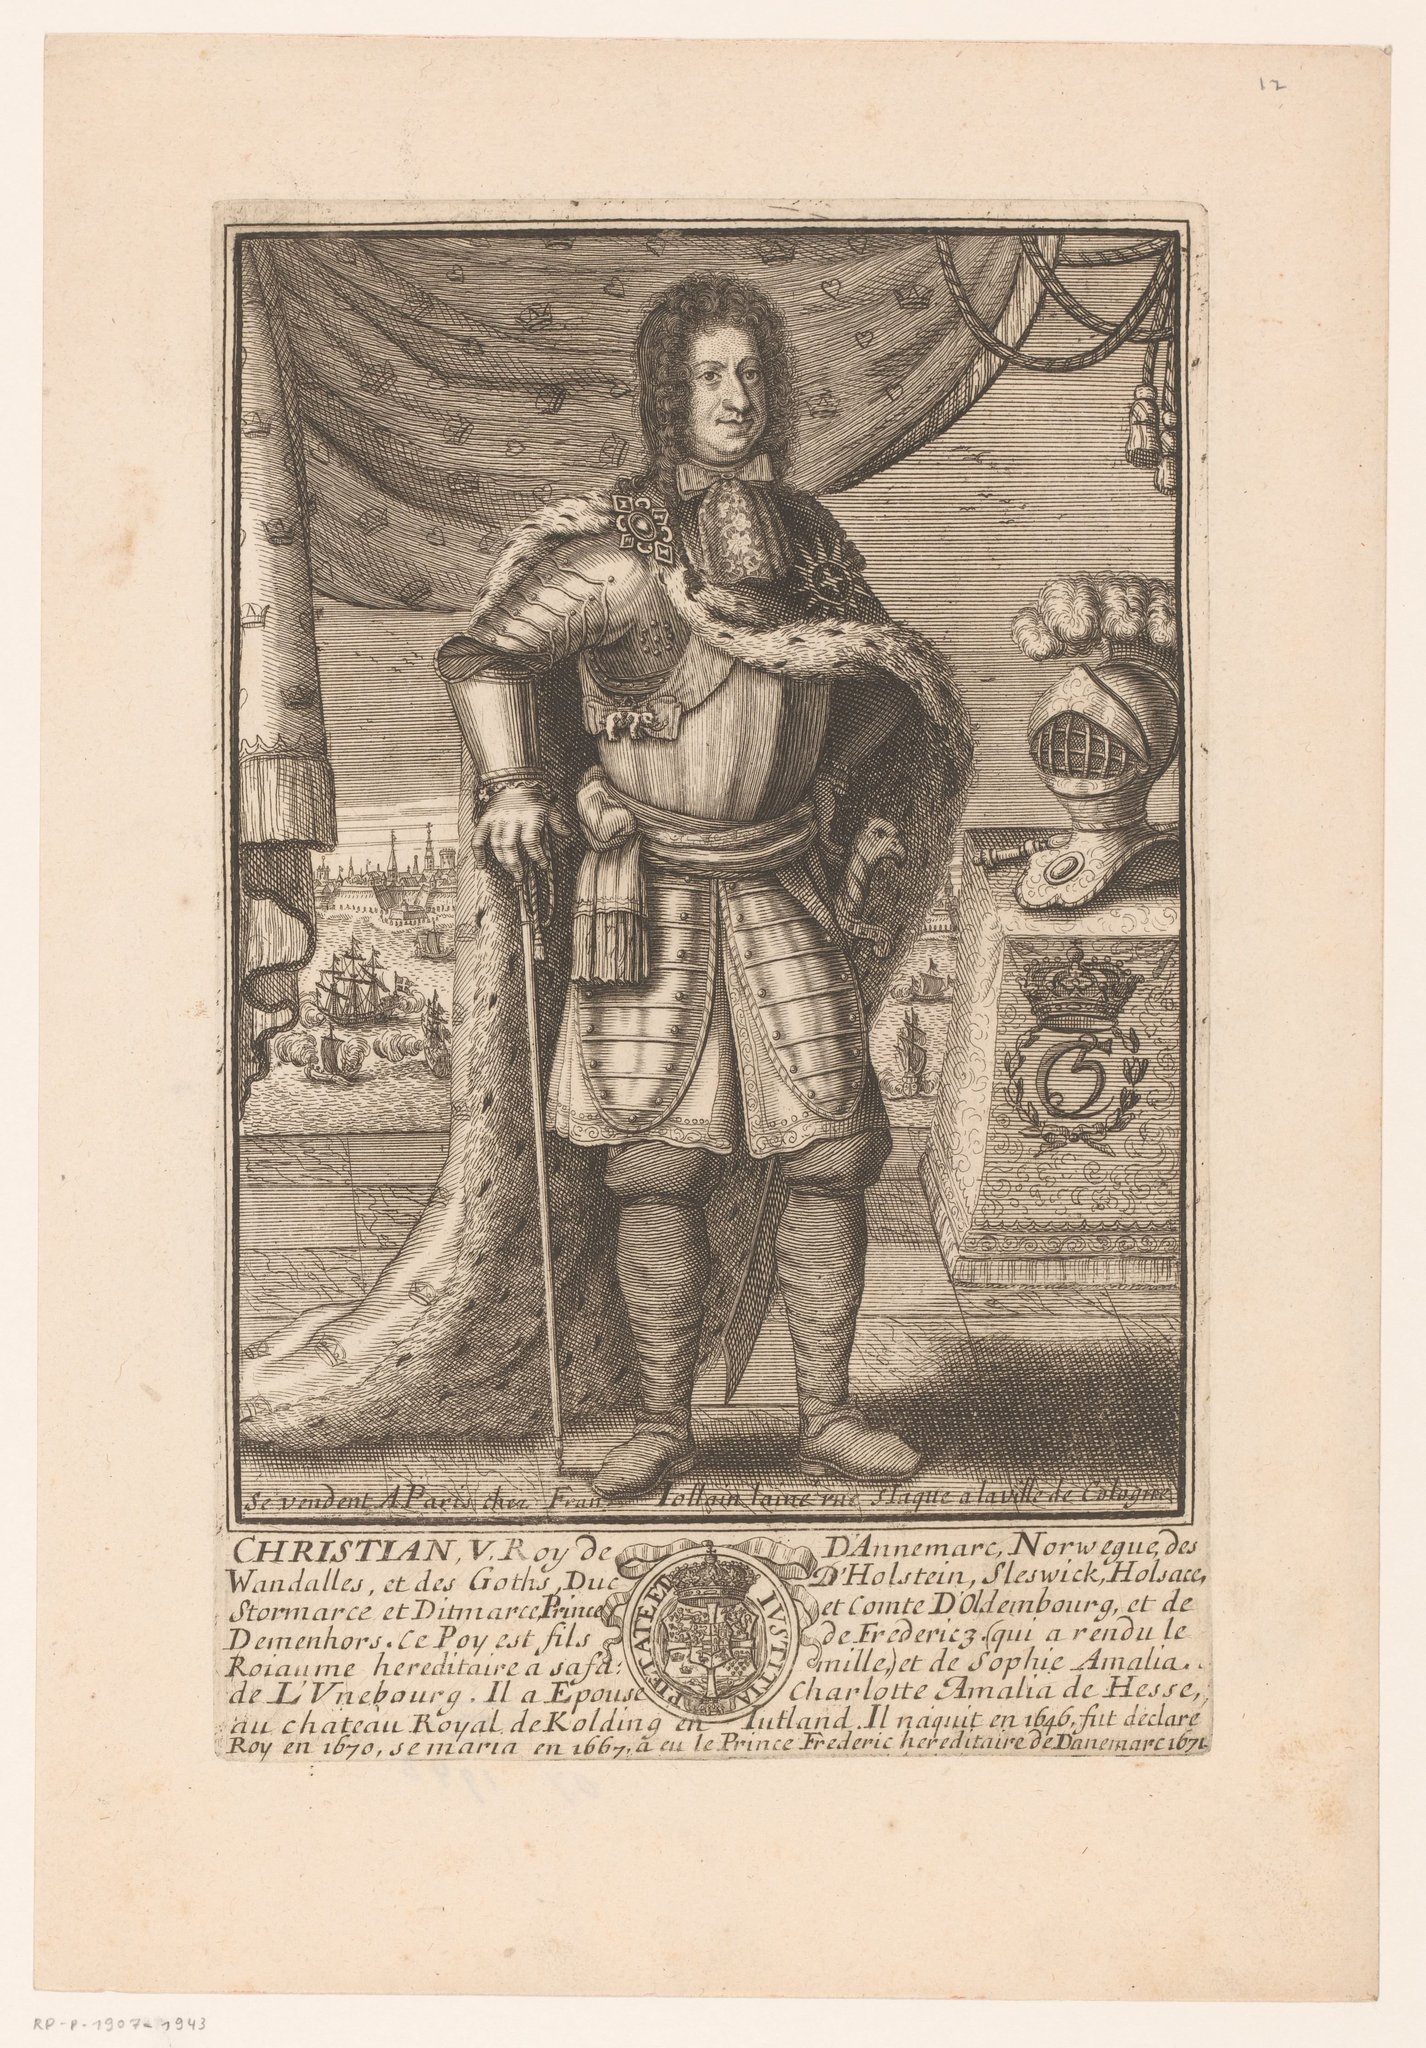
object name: print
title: Portret van Christiaan V van Denemarken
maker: françois jollain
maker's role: print maker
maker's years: 1641-1704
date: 1671-1704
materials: paper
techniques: engraving, etching, intaglio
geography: paris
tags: copenhagen (city), armour, historical persons, ruler, sovereign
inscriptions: collector's mark: Lugt 2228